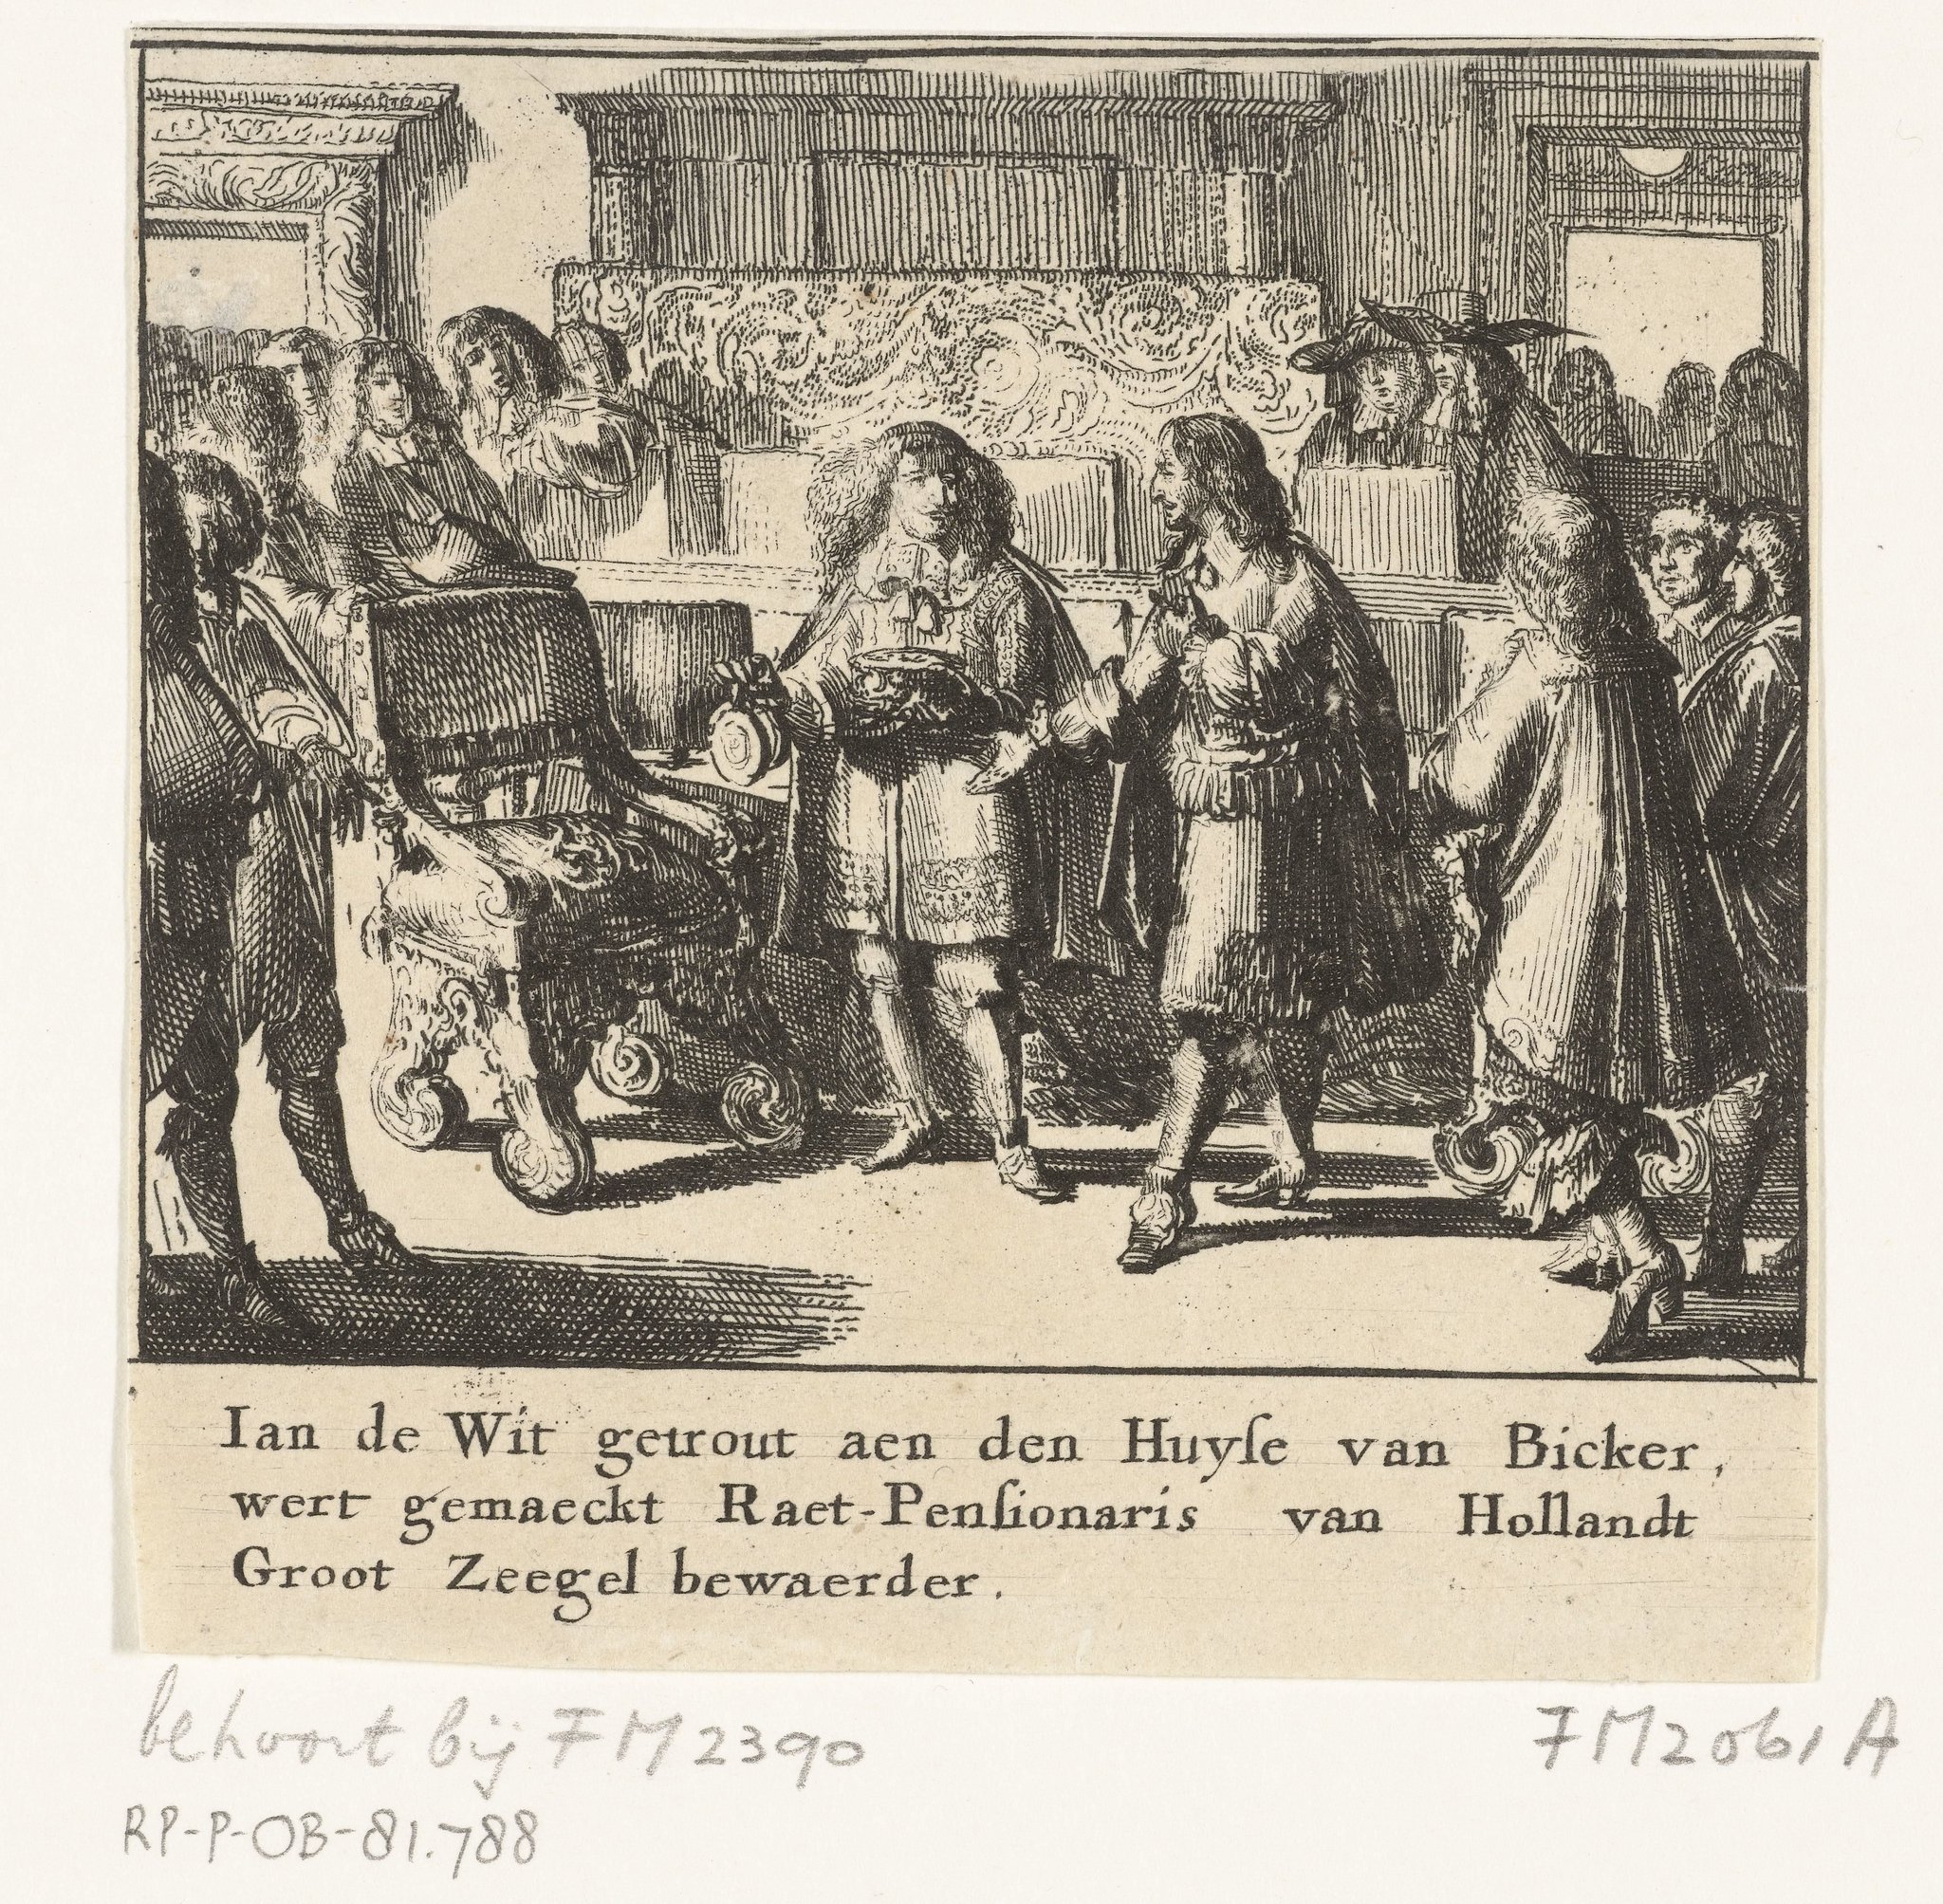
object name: print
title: Johan de Wit wordt benoemd tot raadpensionaris van Holland, 1653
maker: romeyn de hooghe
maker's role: draughtsman, goldsmith, painter, print maker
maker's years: 1645-1708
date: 1675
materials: paper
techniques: etching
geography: northern netherlands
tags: the hague, politician, johan de witt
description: Johan de Wit wordt benoemd tot raadpensionaris van Holland, februari 1653. Fragment van de grote prent over de gebroeders De Witt: Witten Wonder Spiegel (1675).